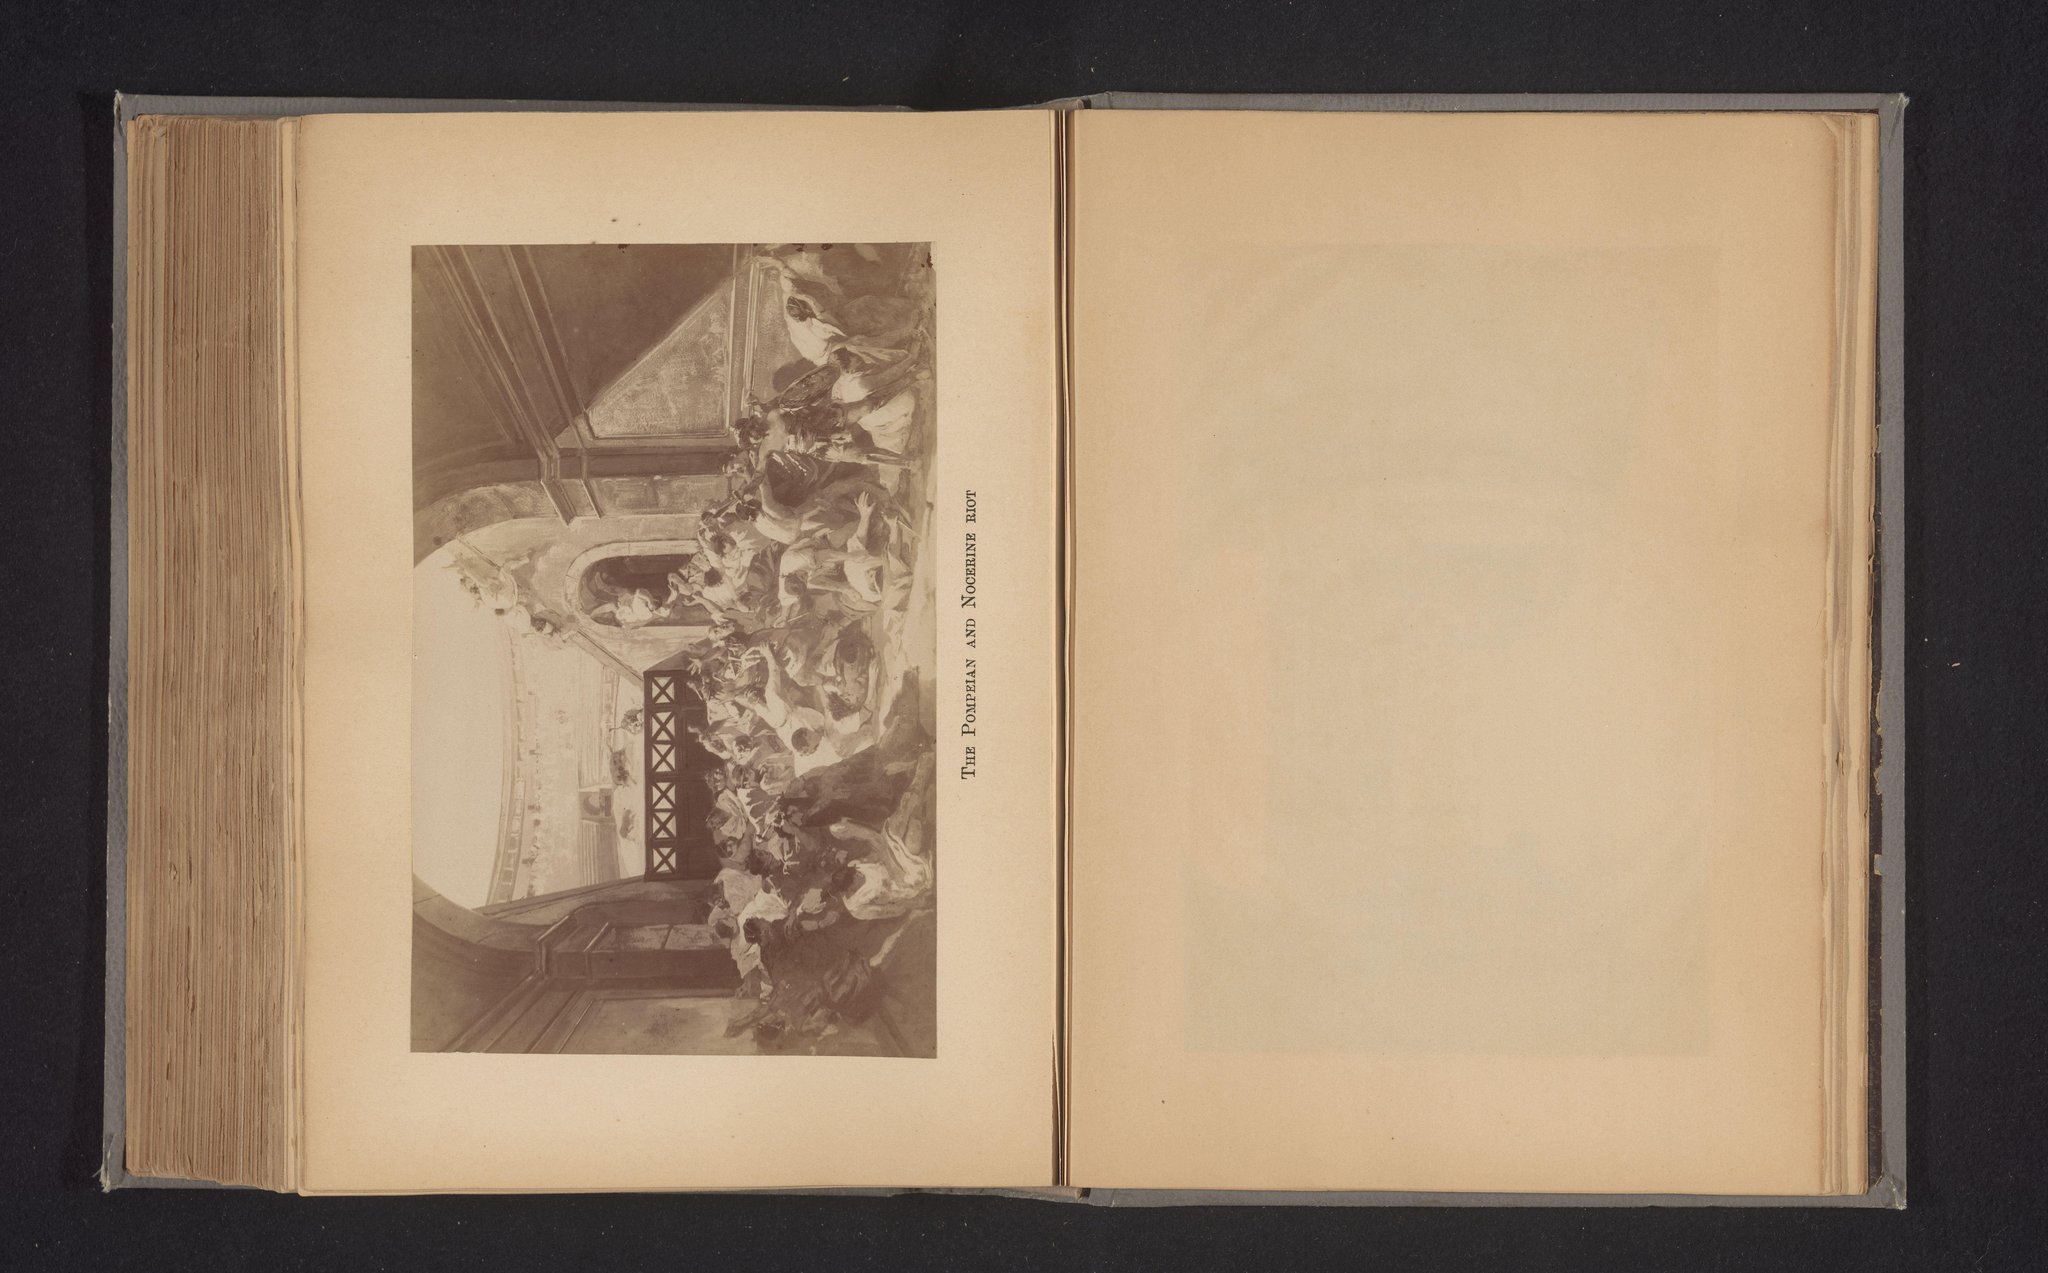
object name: photograph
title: Fotoreproductie van een gezicht op de rel van Pompeï en Nocerino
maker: Anonymous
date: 1890-1895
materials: photographic support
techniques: albumen print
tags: fight of gladiators, street-fights, riots, pompeii